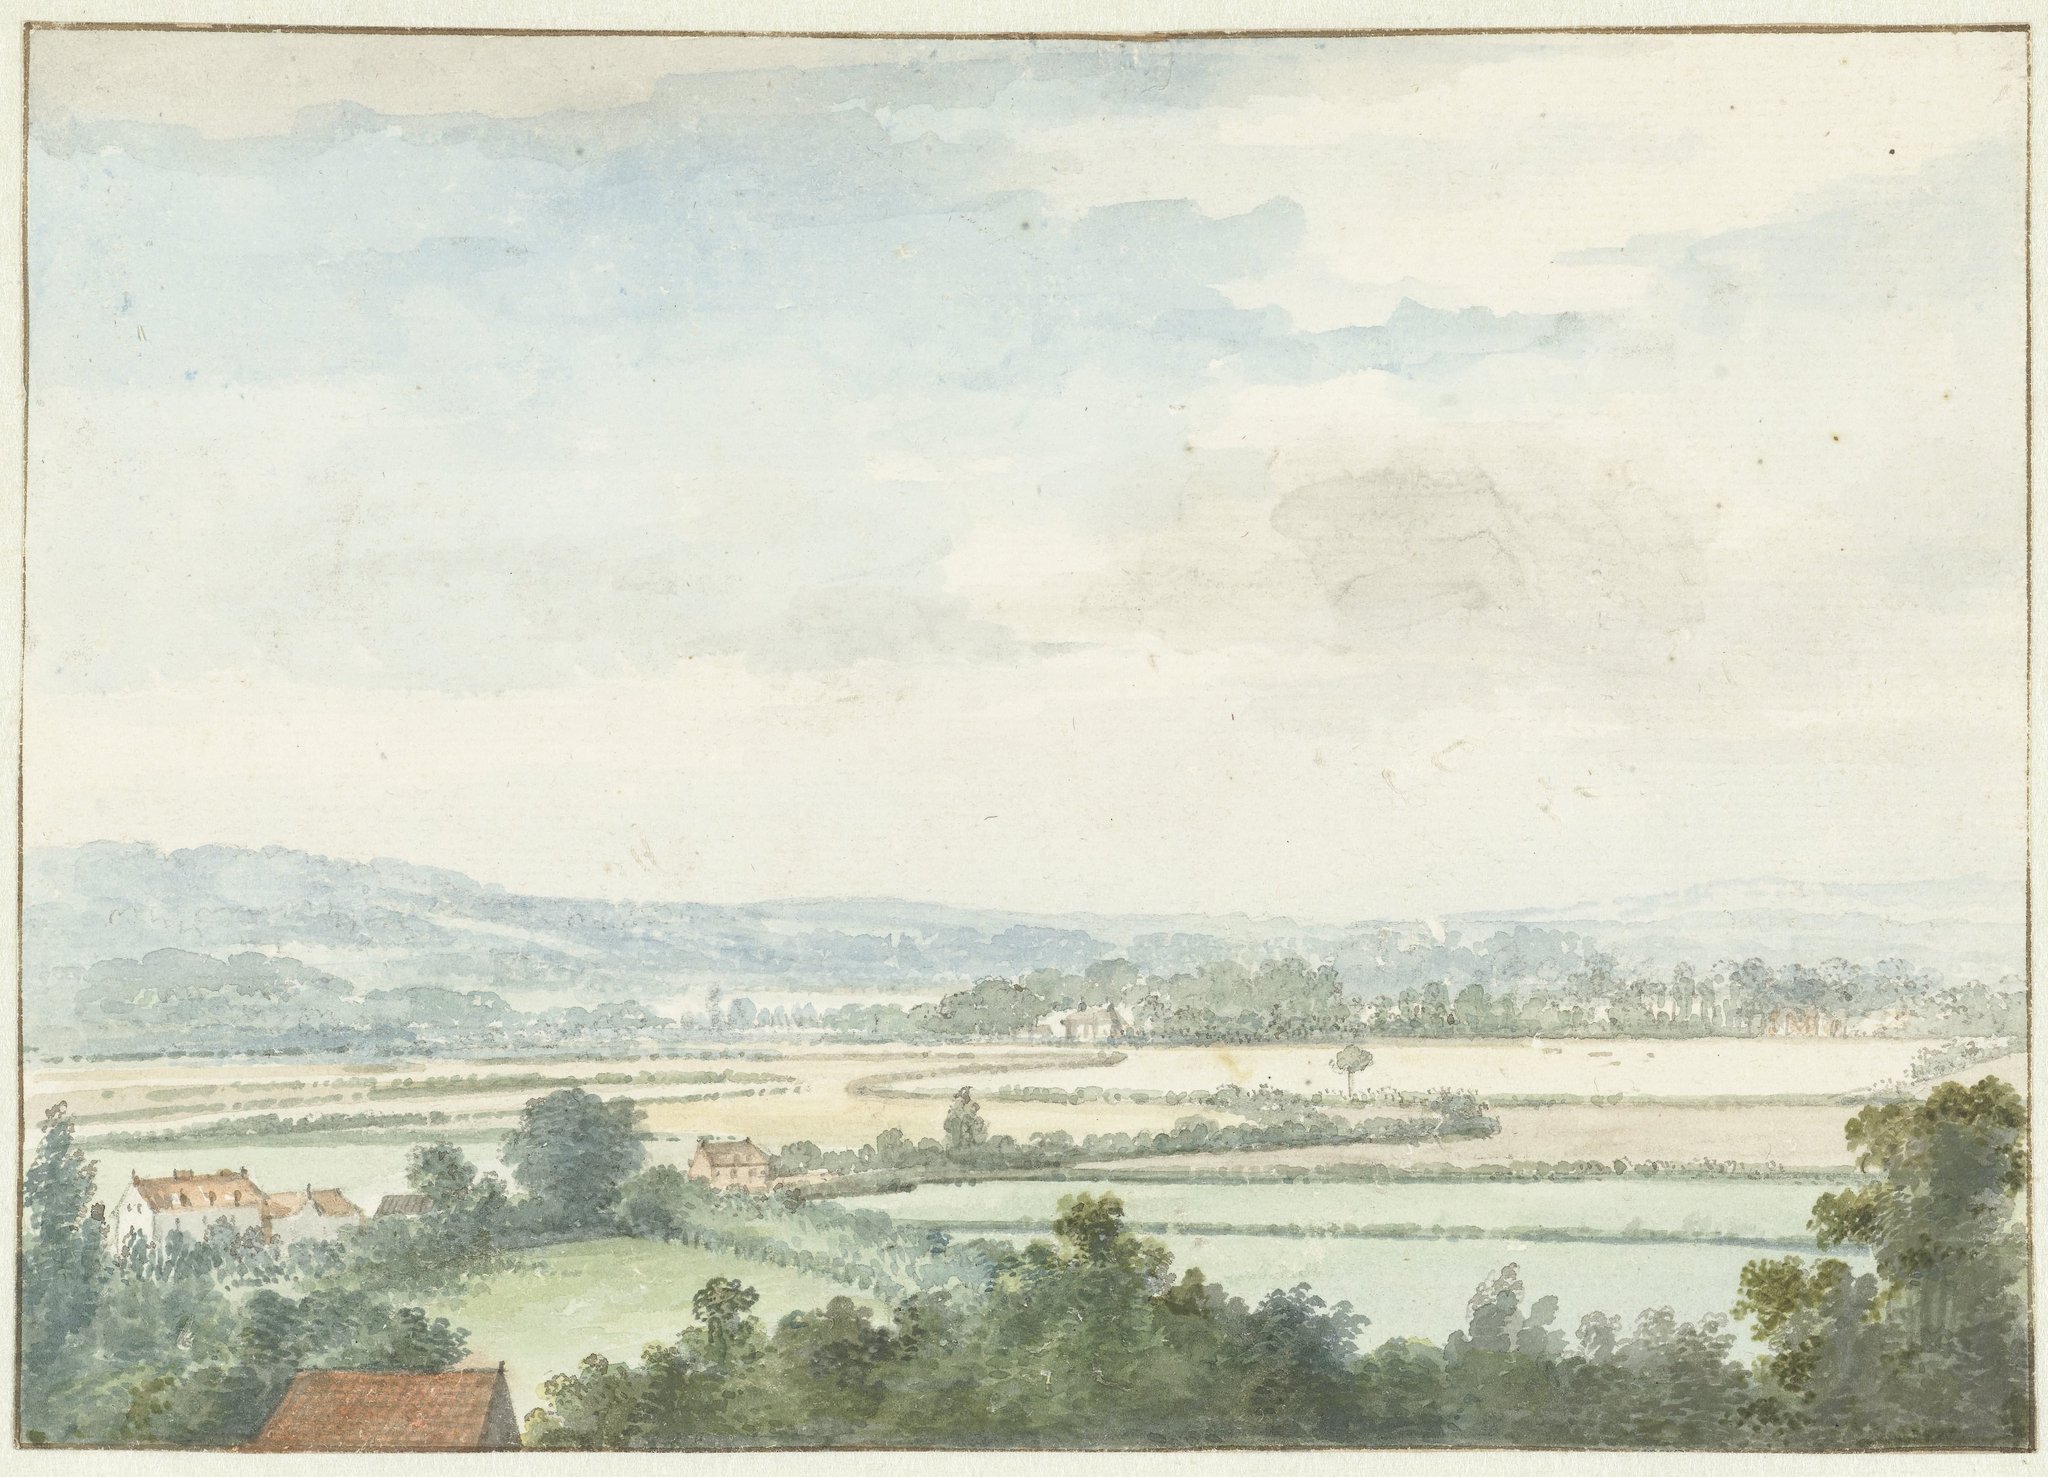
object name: drawing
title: Landschap bij Windsor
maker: aert schouman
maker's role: draughtsman, painter, print maker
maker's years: 1710-1792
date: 1765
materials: paper, watercolor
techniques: brush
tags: landscapes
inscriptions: inscription: ‘Dit heb ik geteekent uyt het Logement t witte Hert te / winsor 1765’